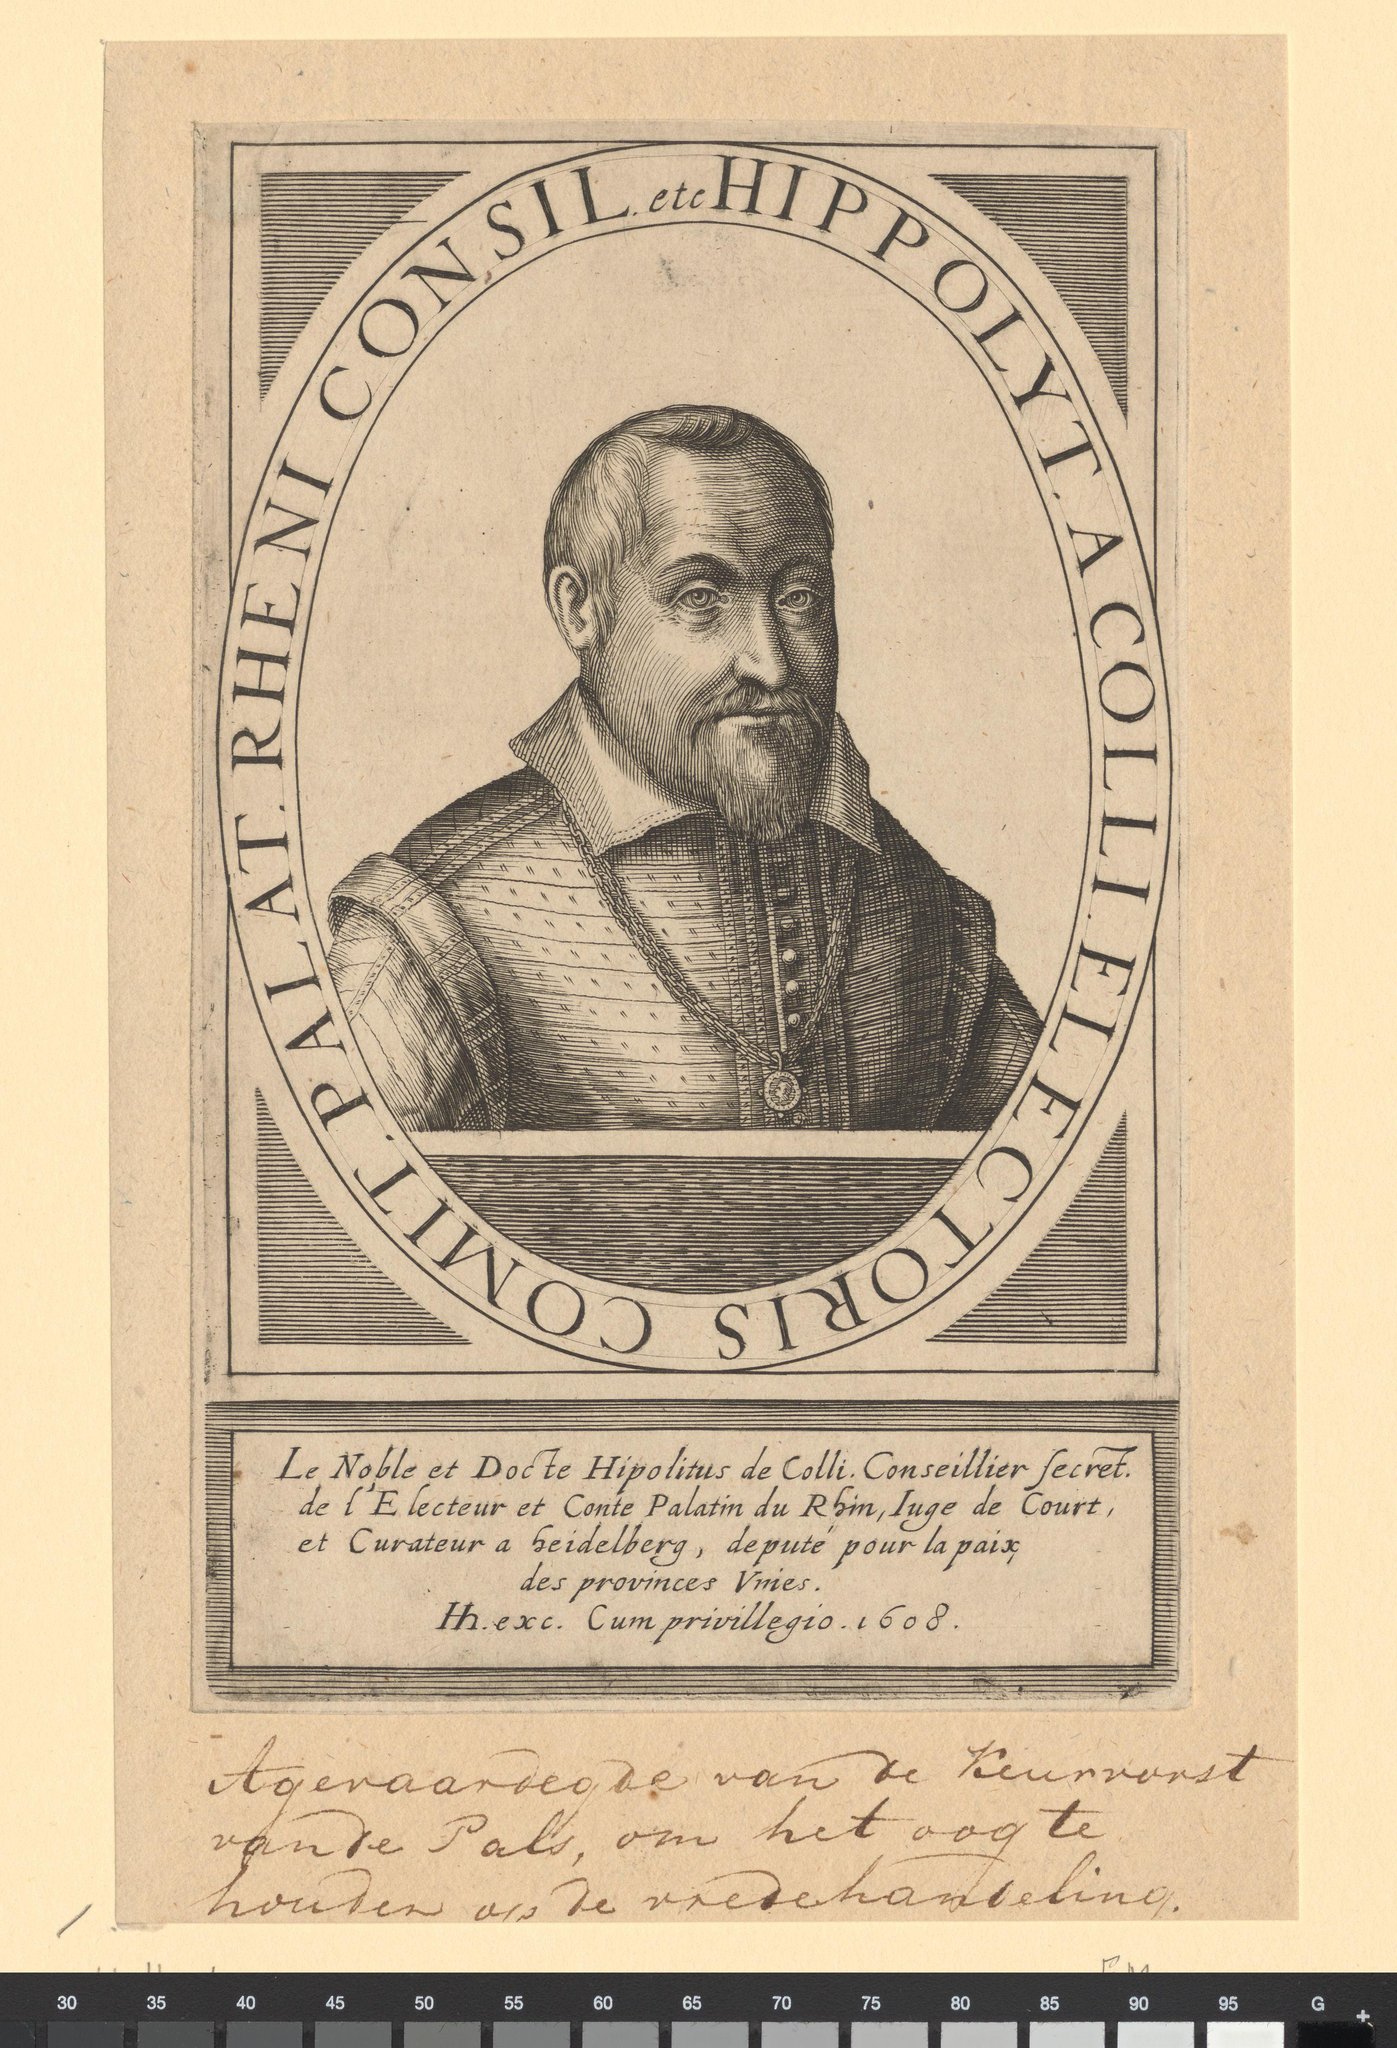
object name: print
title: Portret van Hippolyt von Colli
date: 1608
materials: paper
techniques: engraving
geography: the hague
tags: historical persons, lawyer, attorney at law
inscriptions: inscription: ‘Afgevaardigde van de keurvorst van de Pals, om het oog te houden op de vredehandeling.’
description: Met een vierregelig onderschrift in het Frans.